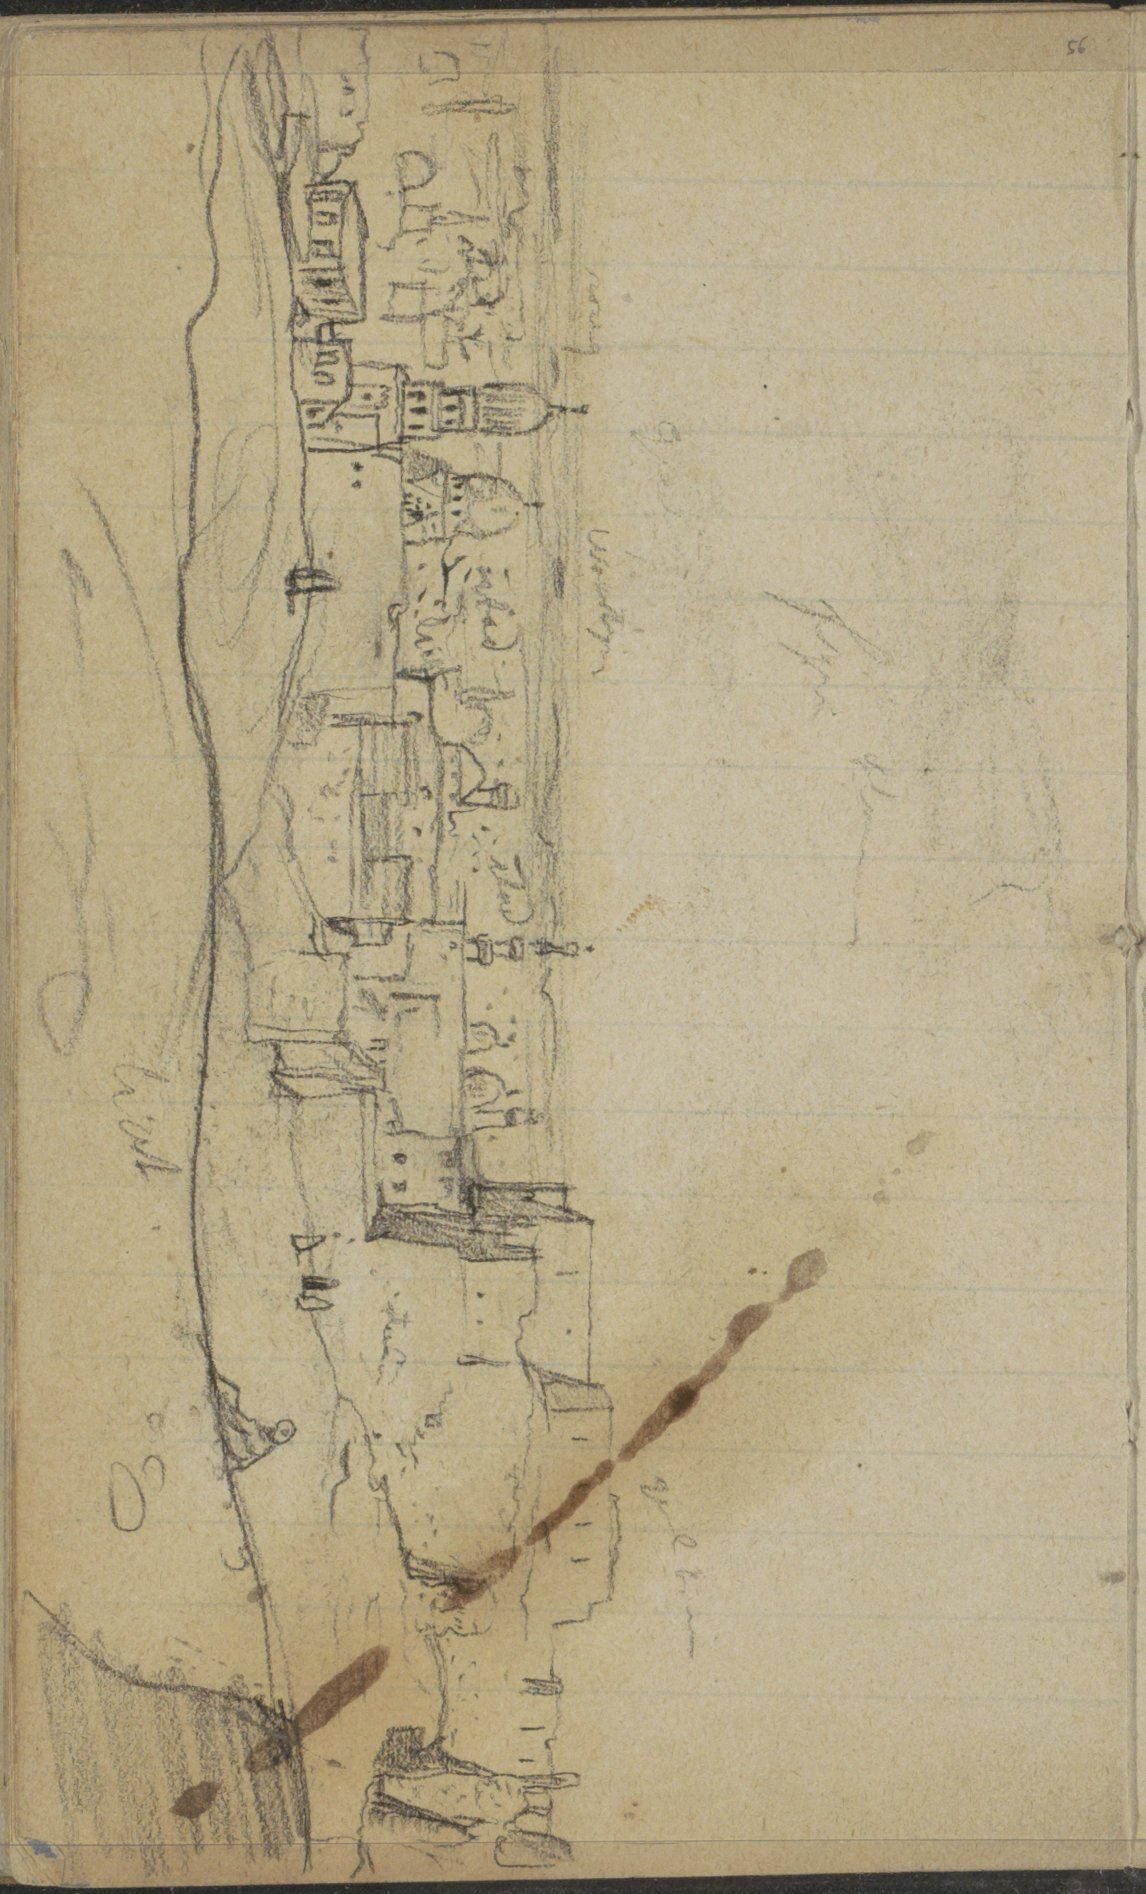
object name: sketchbook leaf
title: Gezicht op Caïro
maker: marius bauer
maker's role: draughtsman, print maker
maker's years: 1867-1932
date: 1894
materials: chalk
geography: cairo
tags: city-view, and landscape with man-made constructions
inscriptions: kleurnotitie, handgeschreven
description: Pagina 56 uit een schetsboek met 48 bladen.